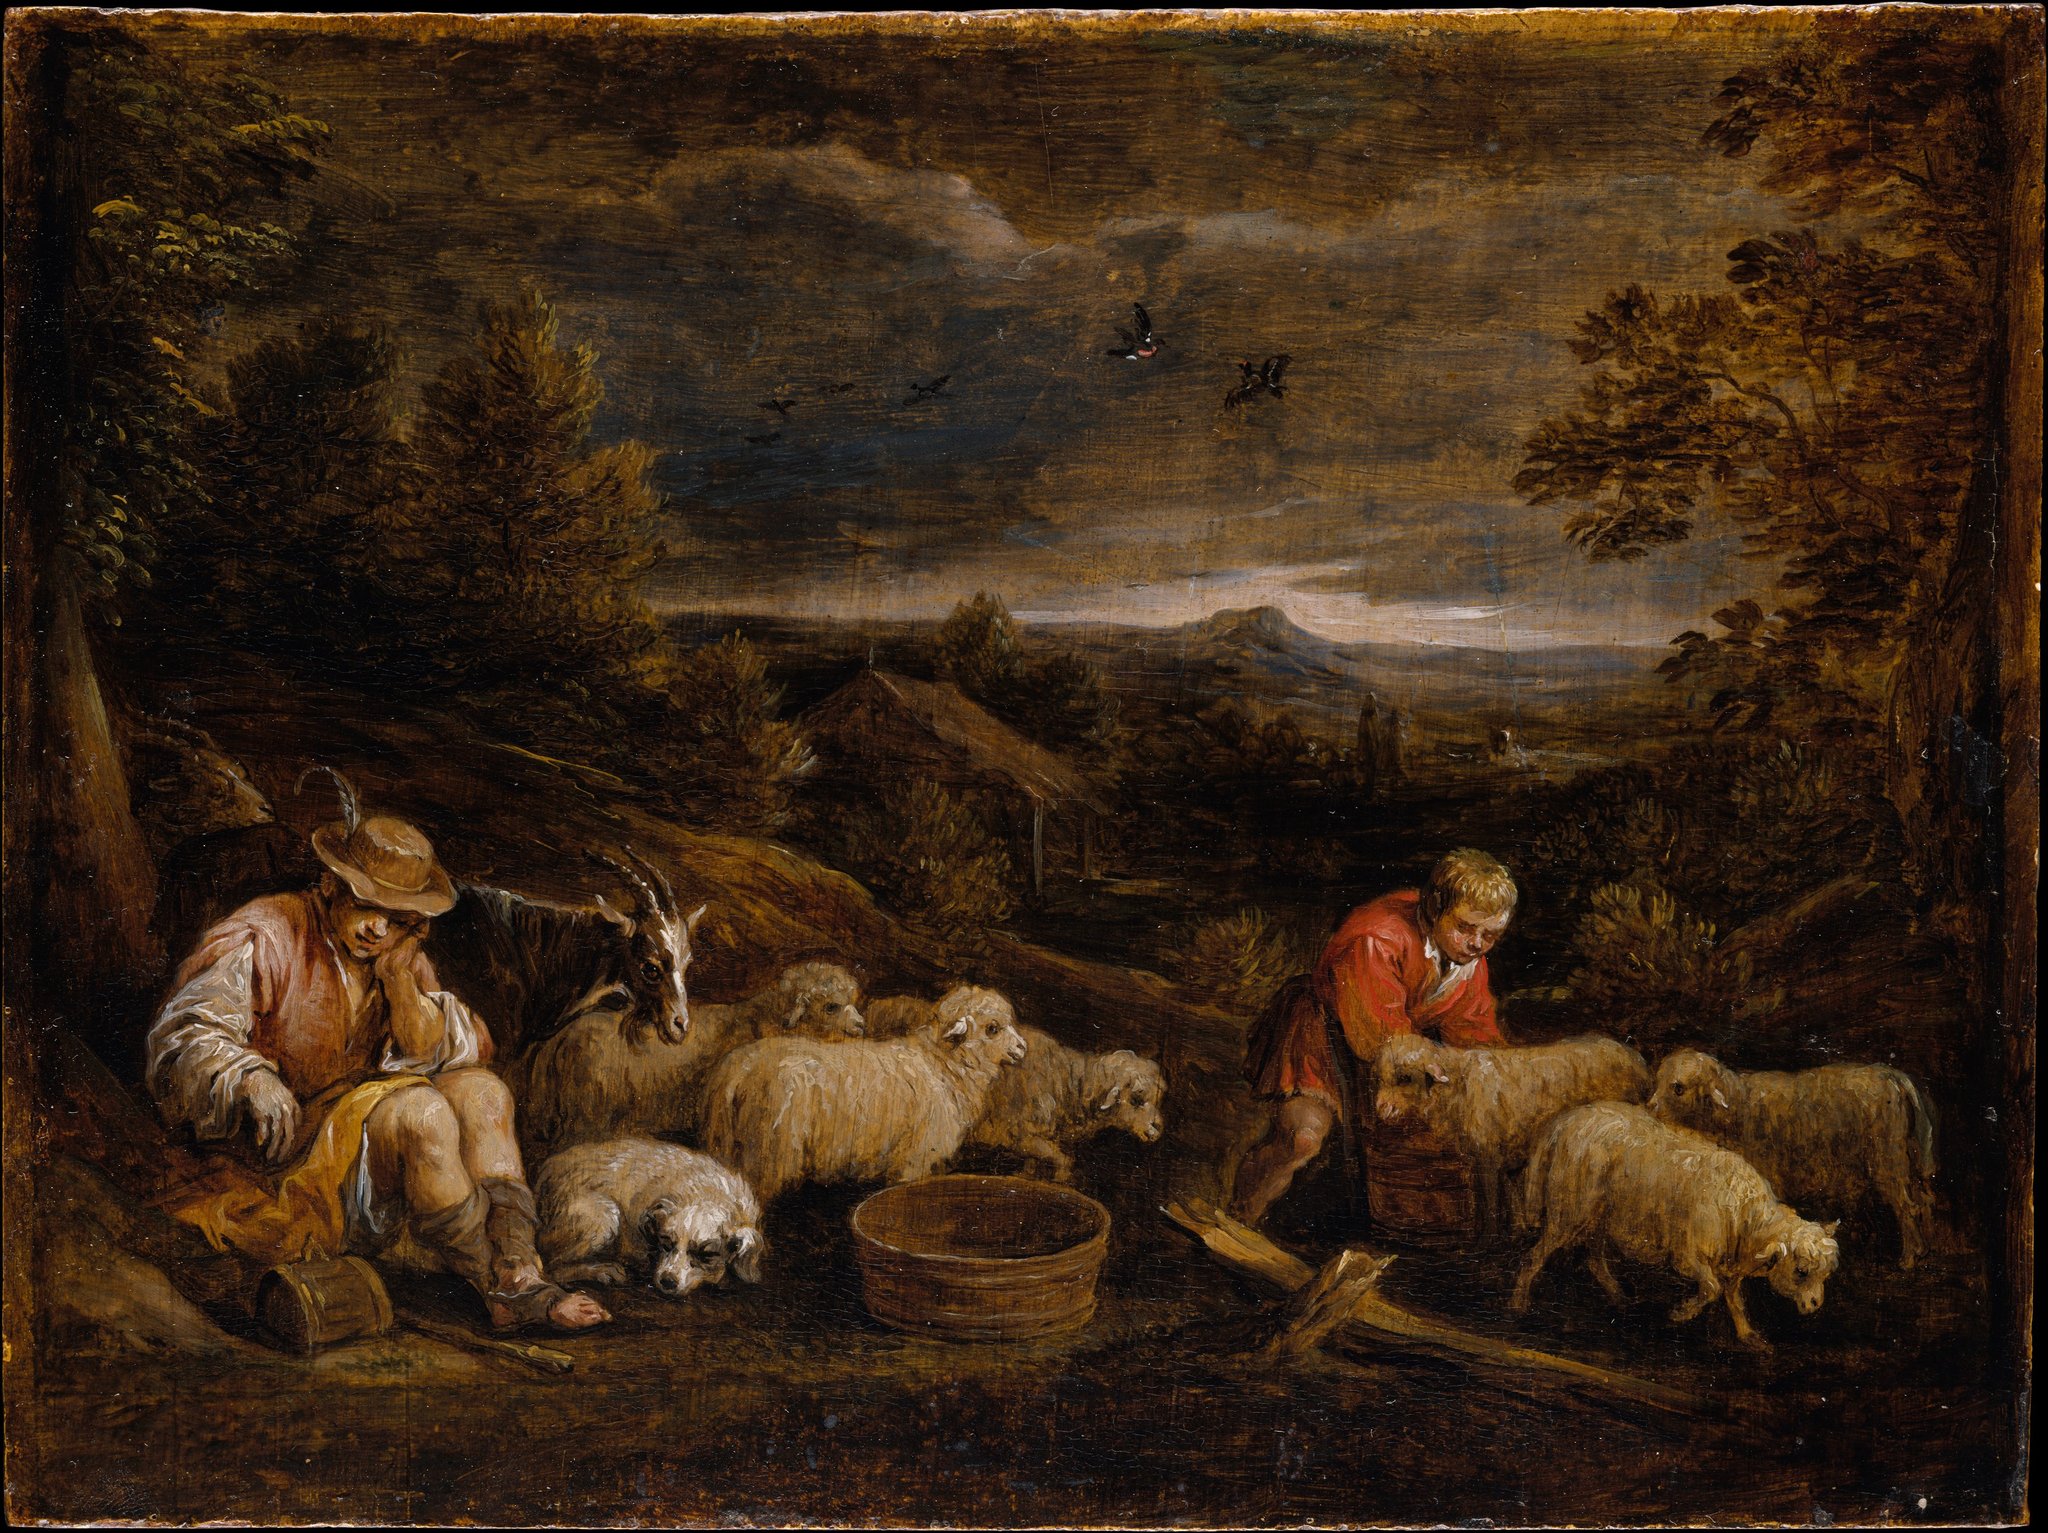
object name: painting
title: Shepherds and Sheep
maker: david teniers the younger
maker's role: artist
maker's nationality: flemish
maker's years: 1610-1690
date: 1630-1690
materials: oil, wood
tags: men,dogs,goats,sheep,shepherds